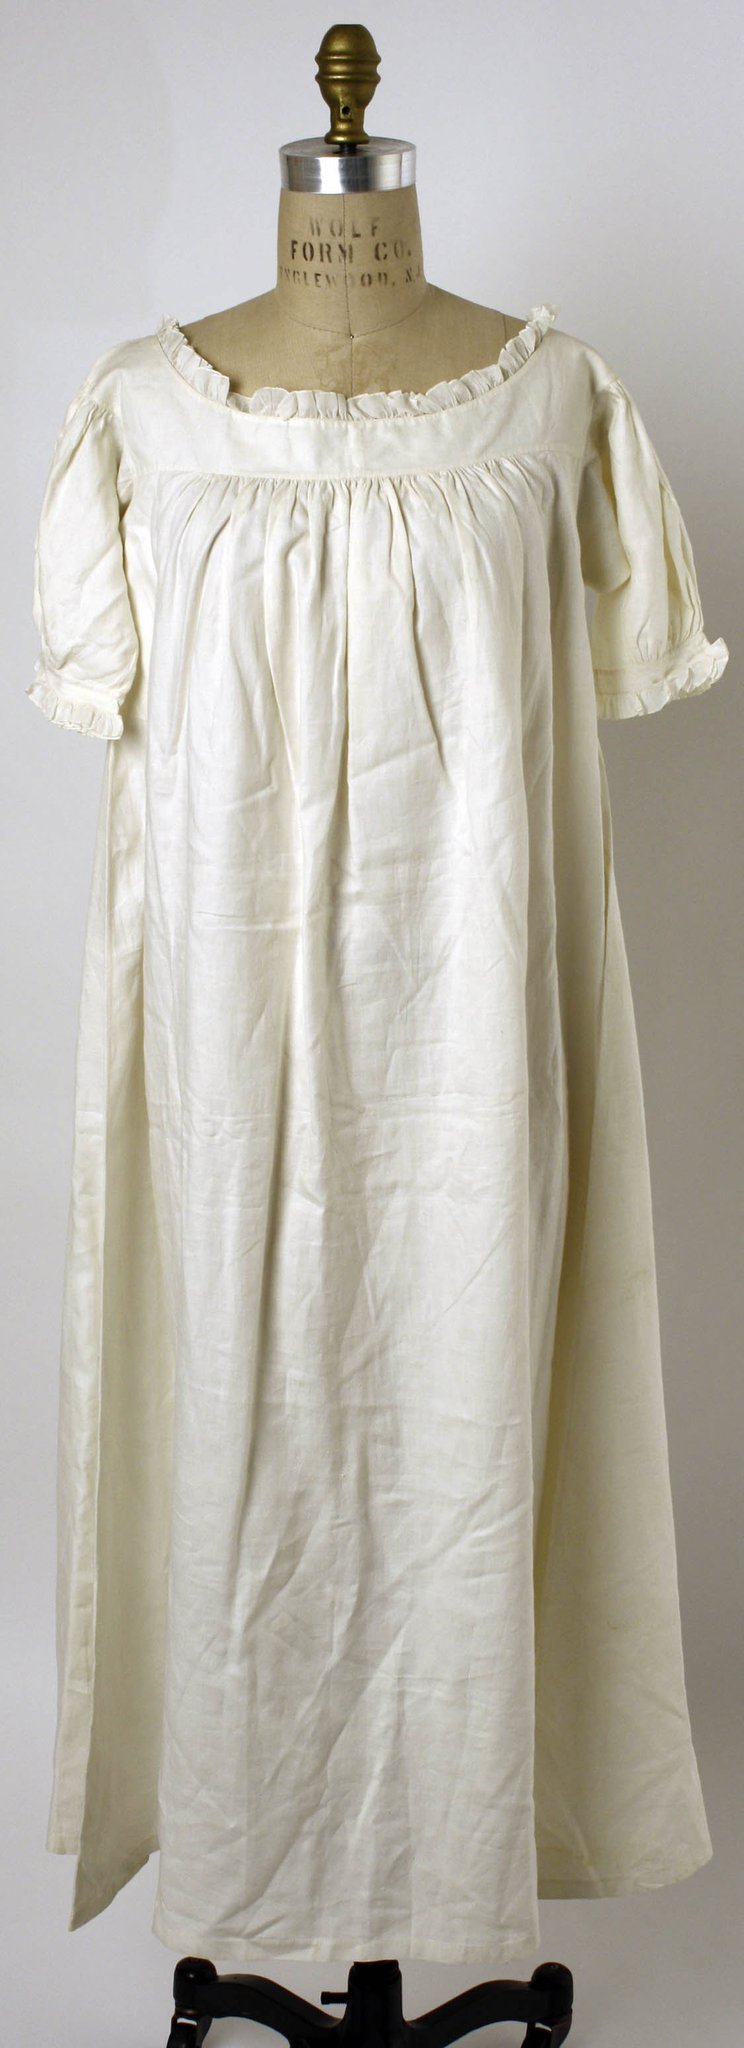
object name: nightgown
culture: american or european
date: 1830-1839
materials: linen